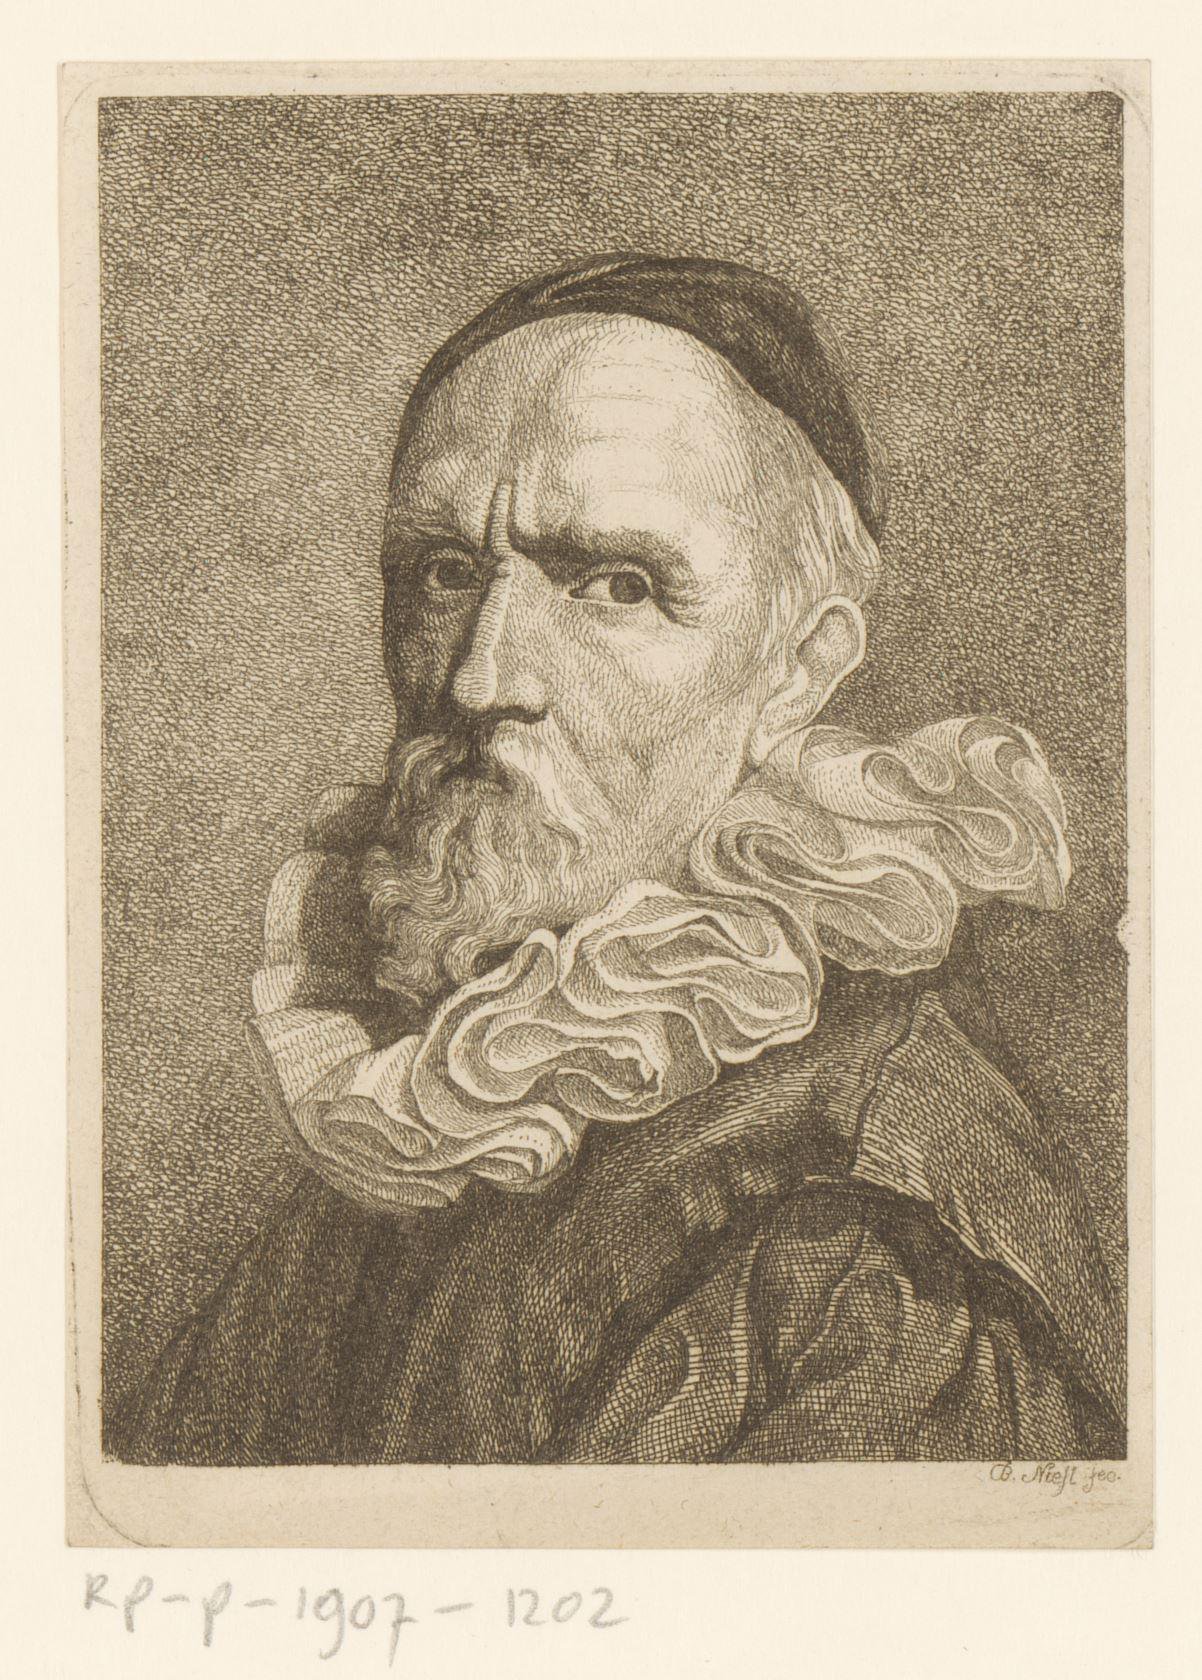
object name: print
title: Portret van Hans de Wael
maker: b. niesl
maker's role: print maker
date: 1700-1799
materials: paper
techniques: etching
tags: painter, hans de wael, historical persons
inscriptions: collector's mark: Lugt 2228